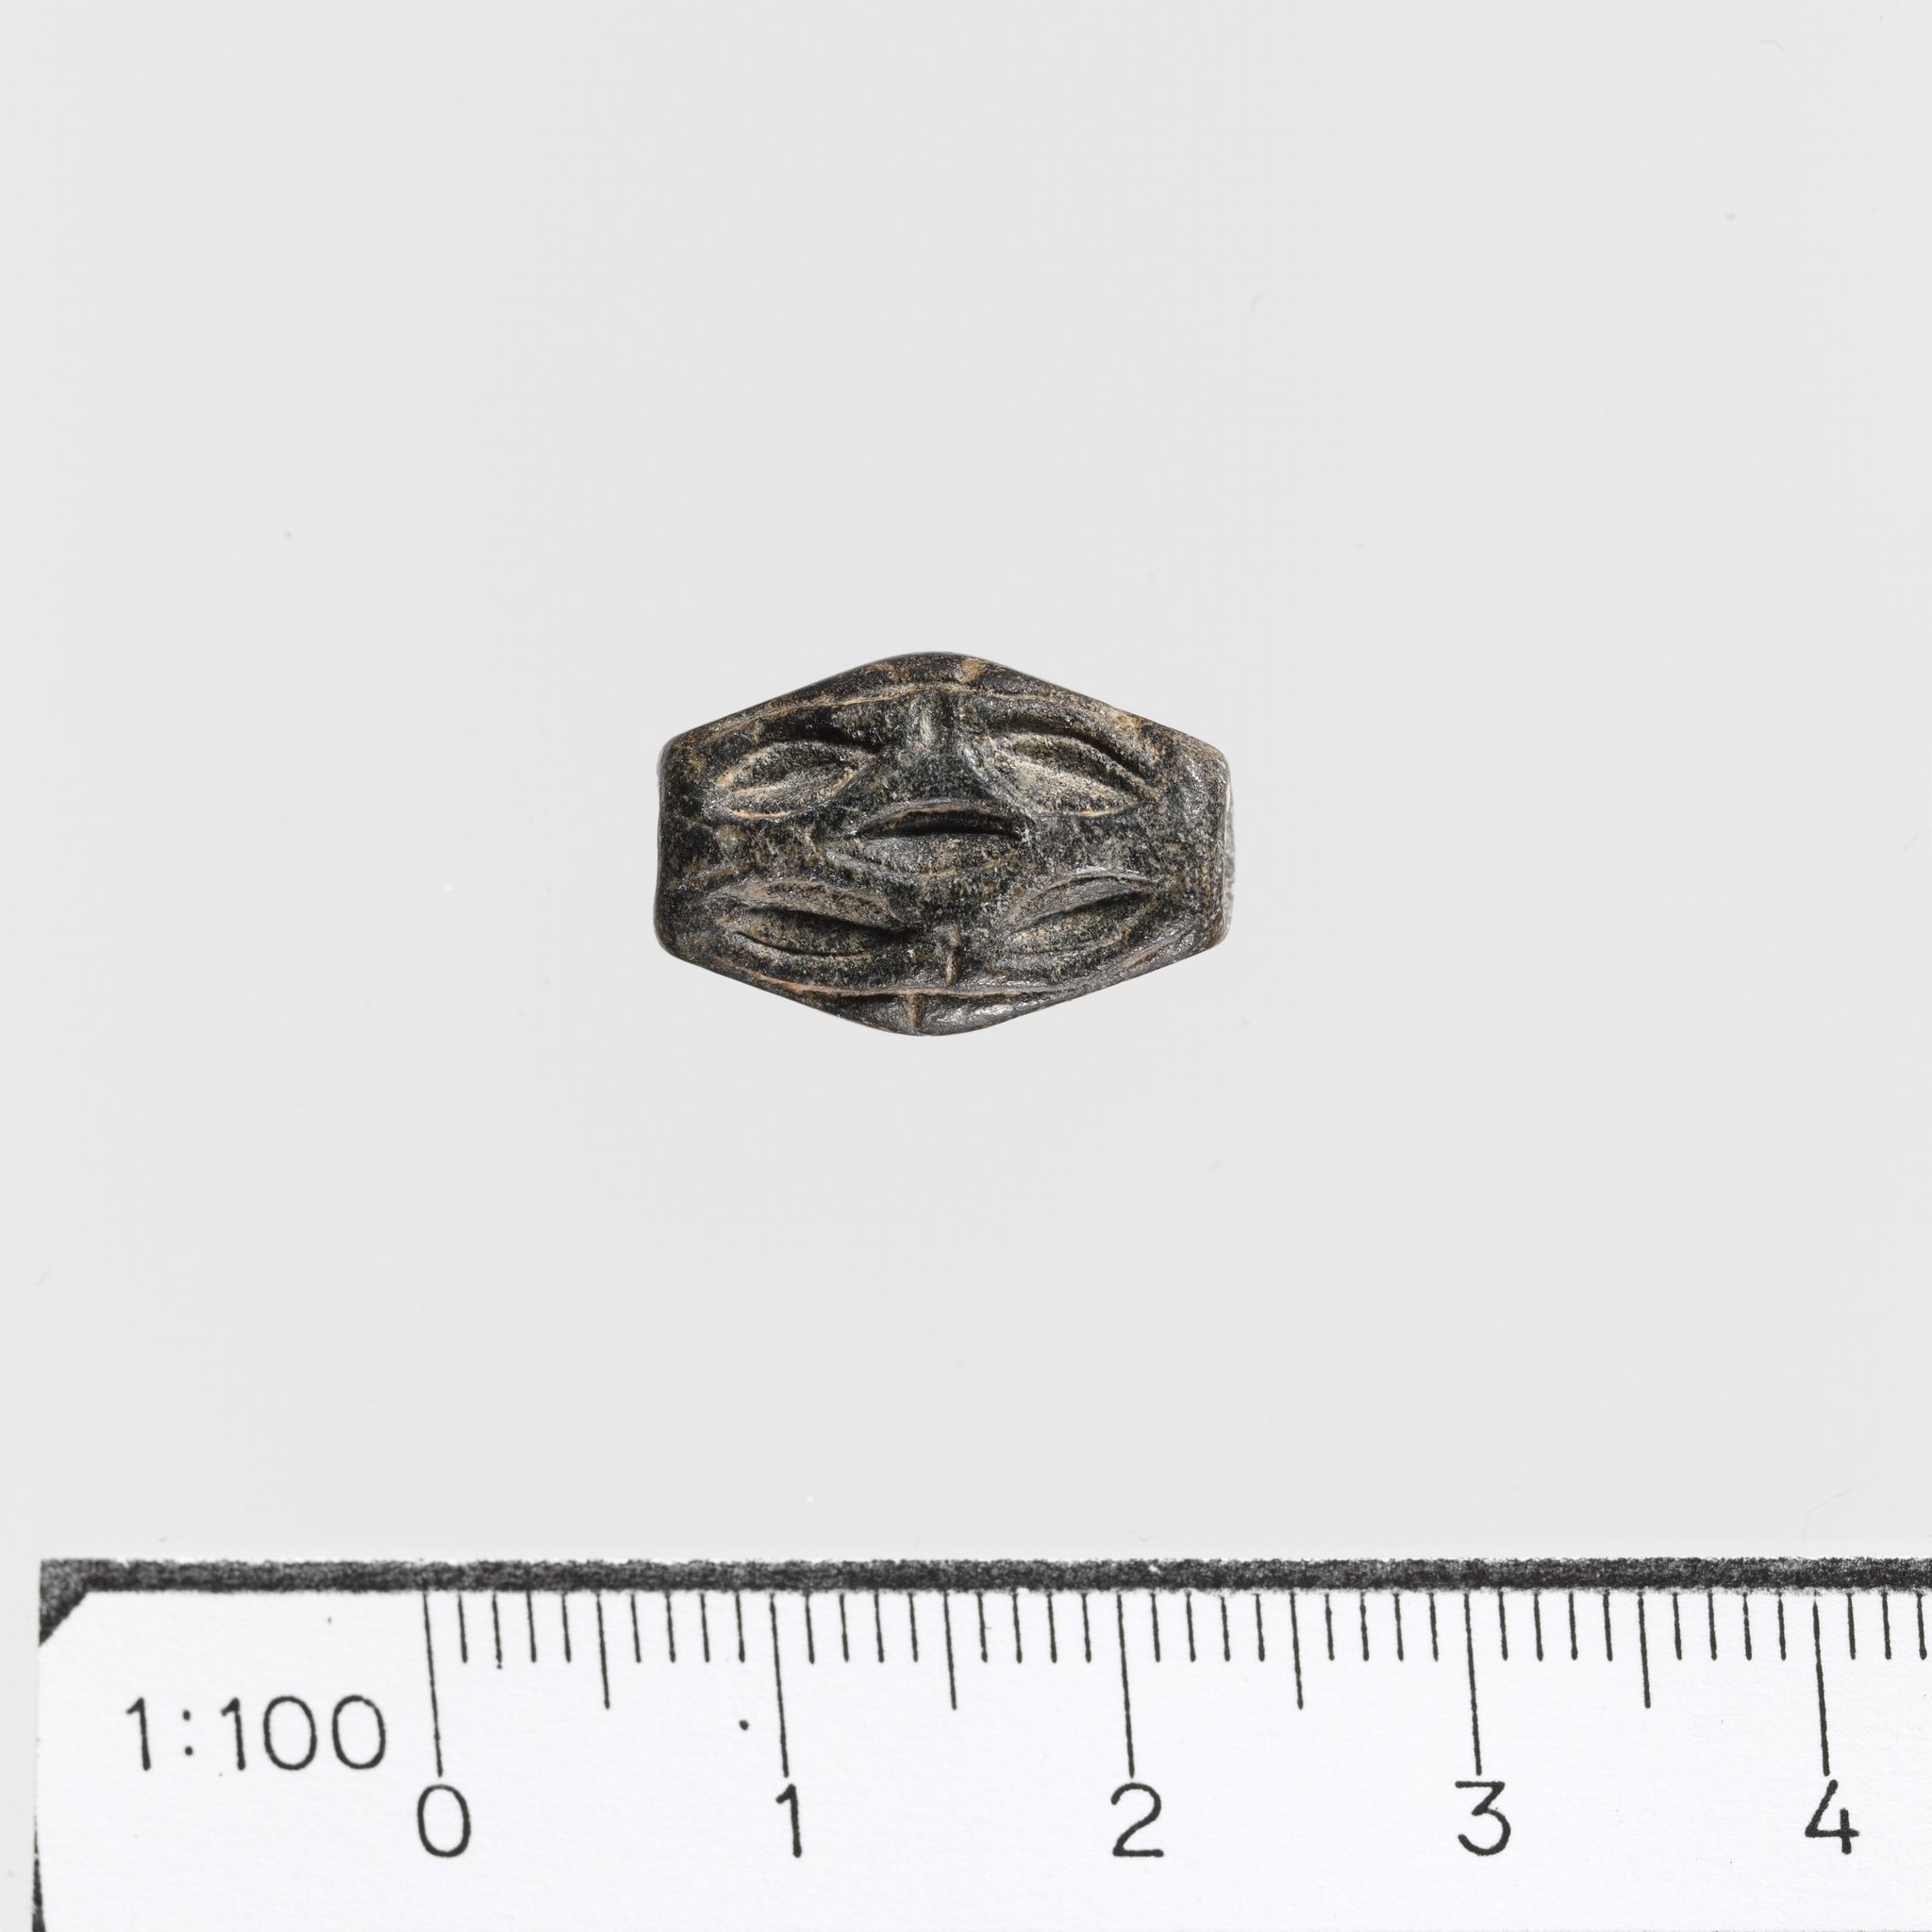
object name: seal, amygdaloid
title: Steatite amygdaloid seal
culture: minoan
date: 1700-1500 BCE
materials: stone